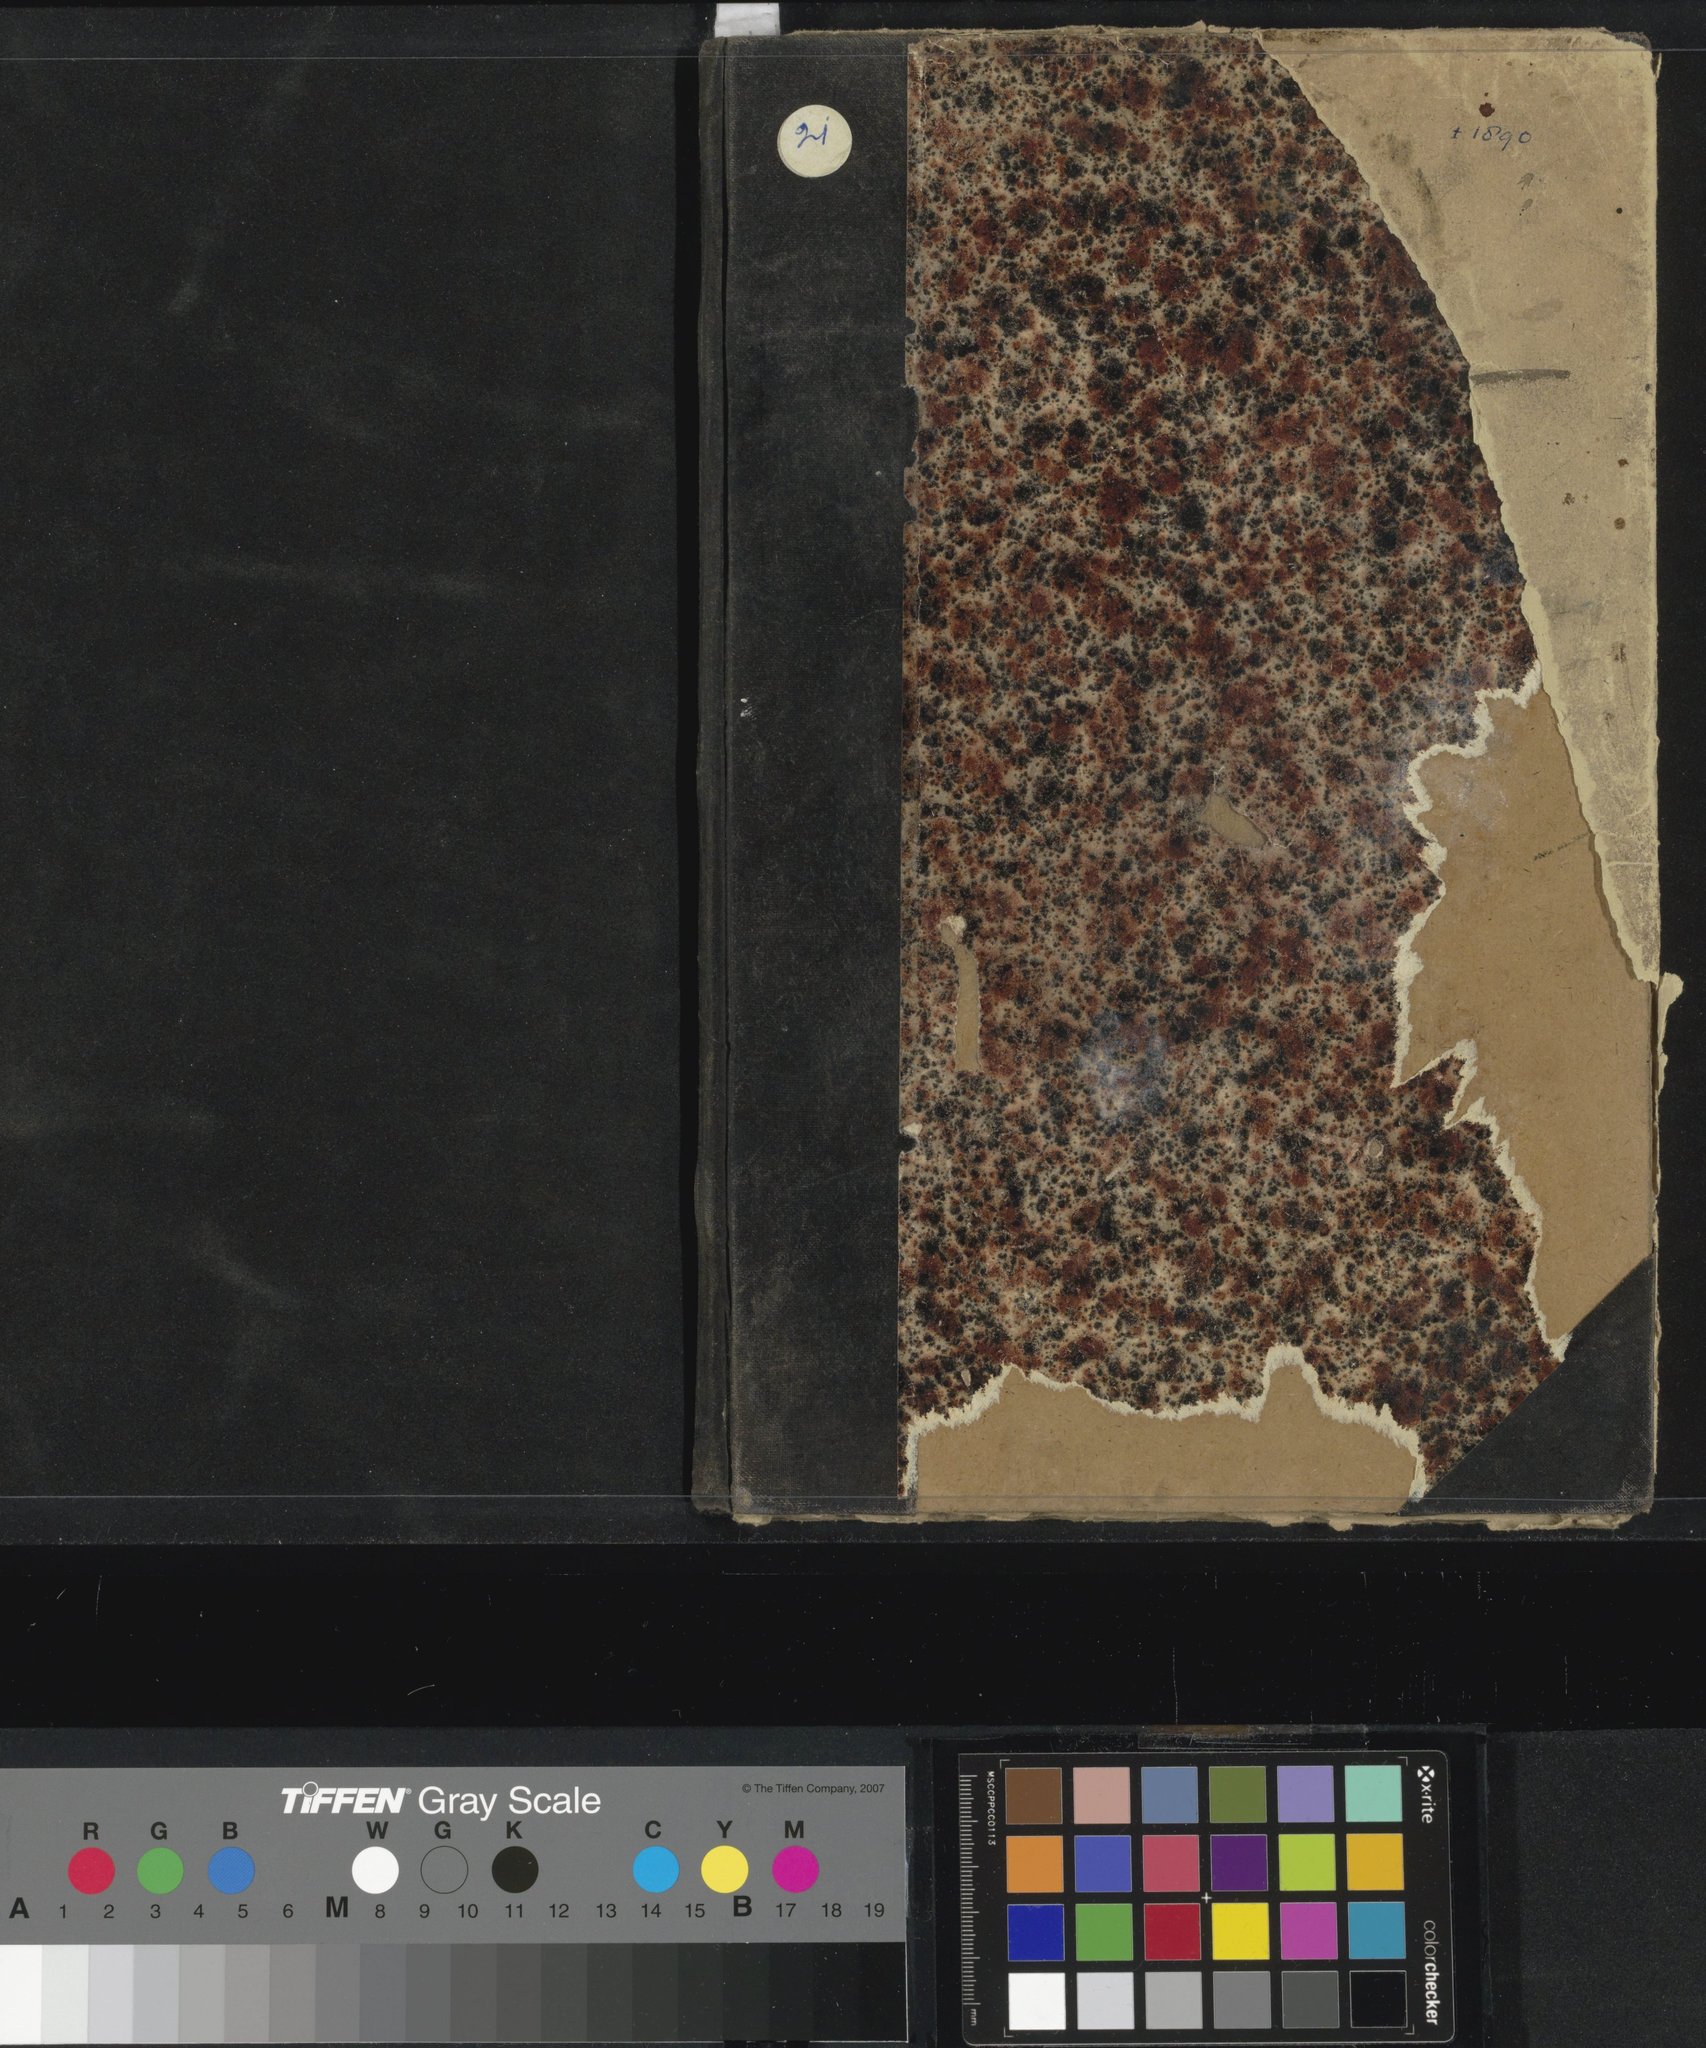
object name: sketchbook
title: Schetsboek met 38 bladen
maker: carel adolph lion cachet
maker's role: draughtsman, print maker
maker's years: 1864-1945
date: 1890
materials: cardboard, chalk, ink, linen, paper, pencil, watercolor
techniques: brush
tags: anatomy (non-medical), ornamental birds: parrot, architecture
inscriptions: collector's mark: Lugt 2228a, date: ‘+- 1890’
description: Schetsboek bestaande uit 38 bladen met voornamelijk figuren, architectuur, stoelen en papegaaien.